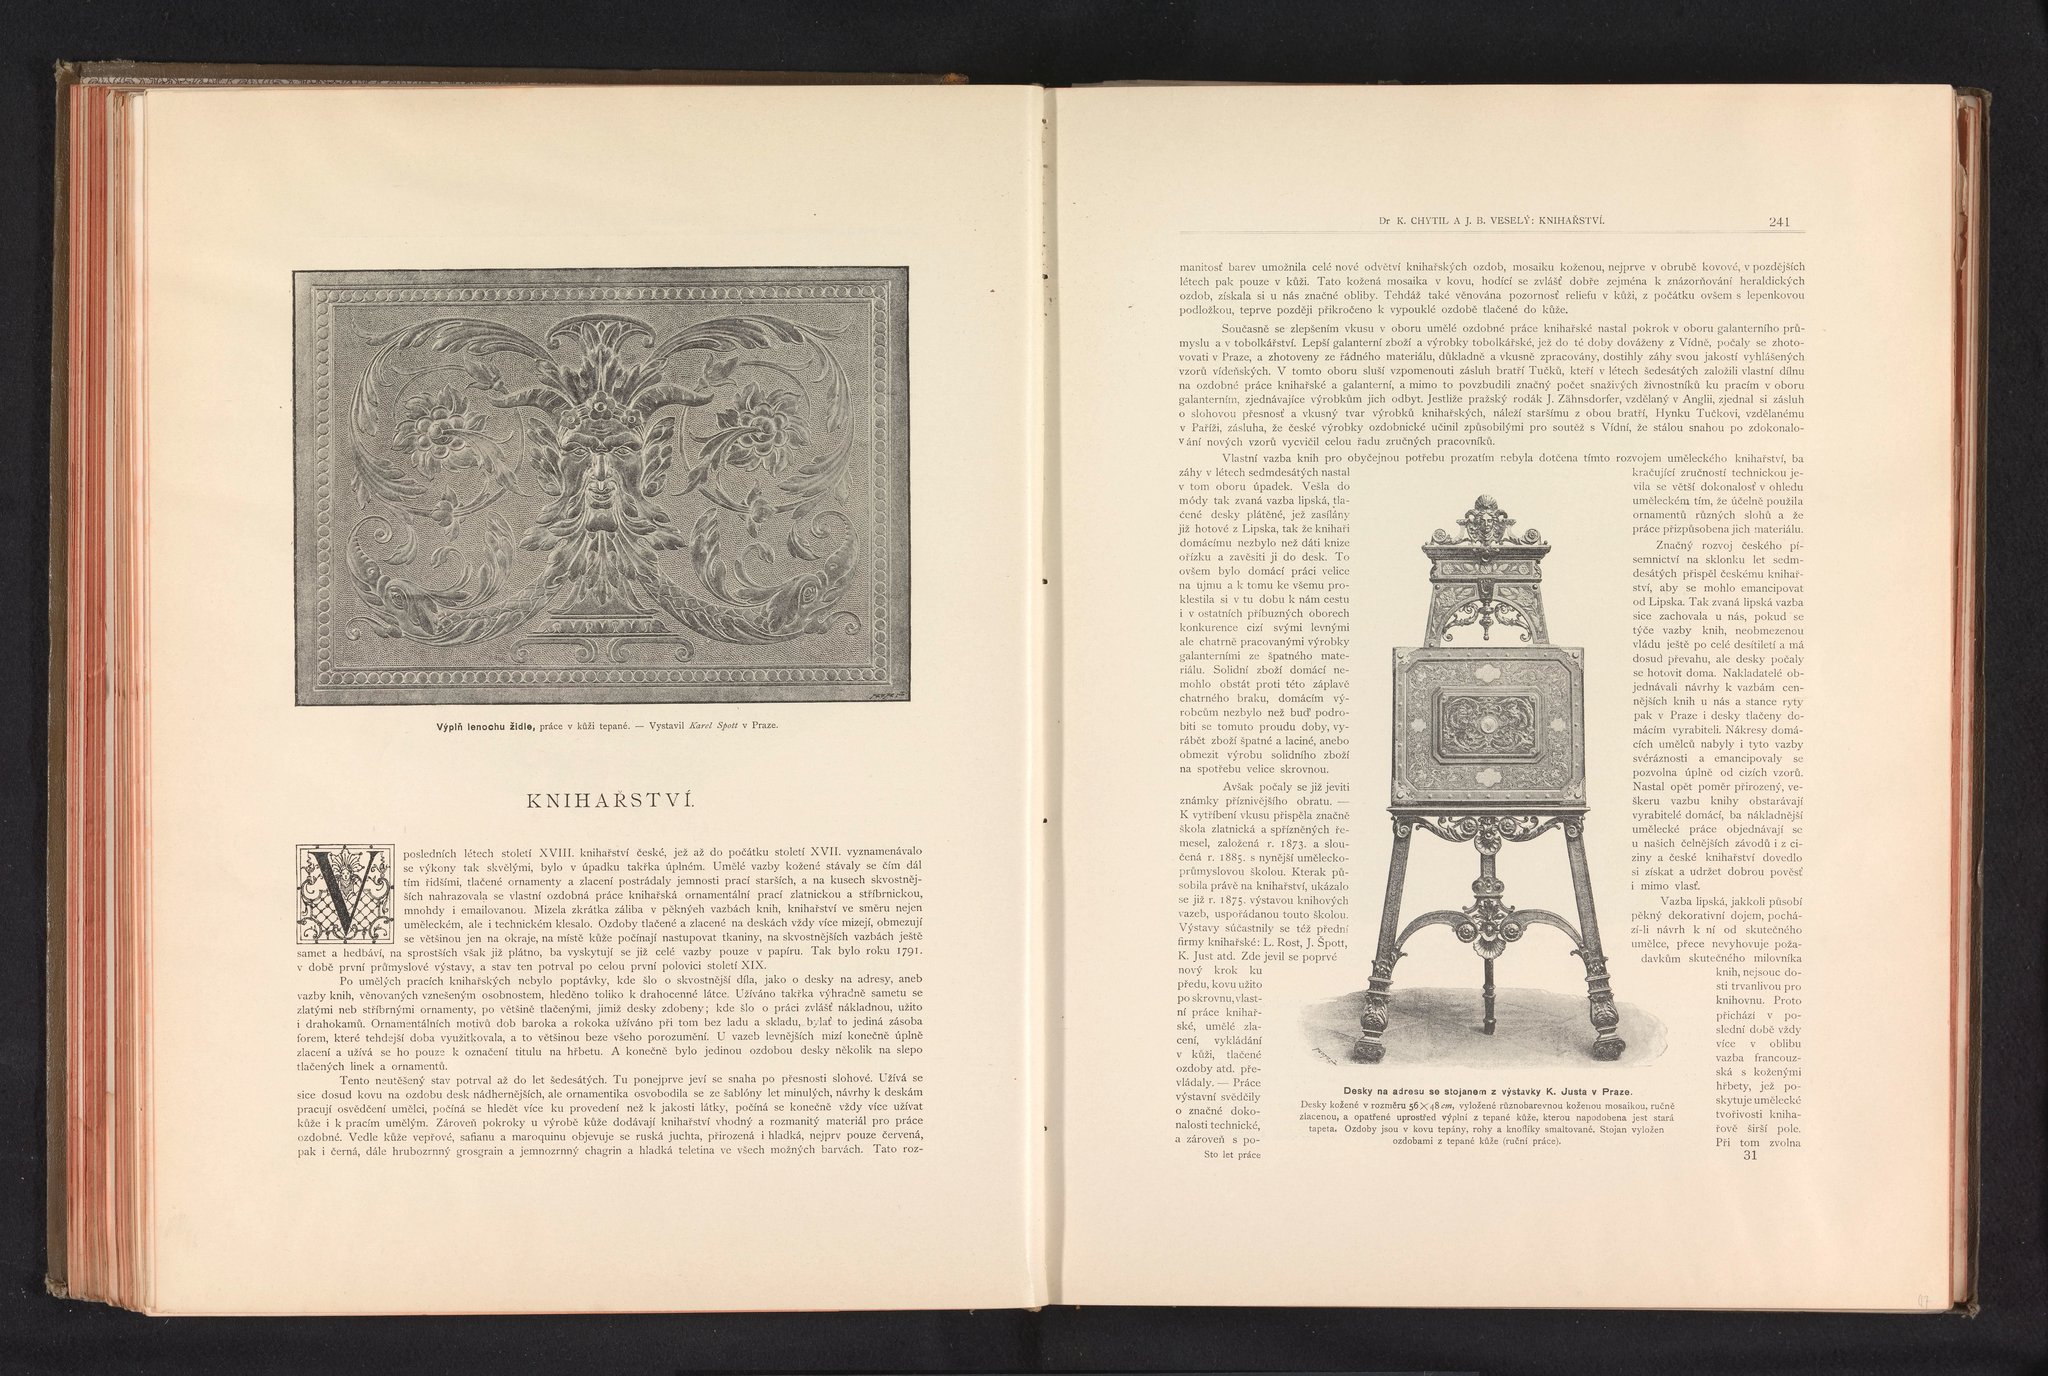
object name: photomechanical print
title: Wegwijsbord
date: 1890-1895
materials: paper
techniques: autotype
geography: prague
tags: tripod